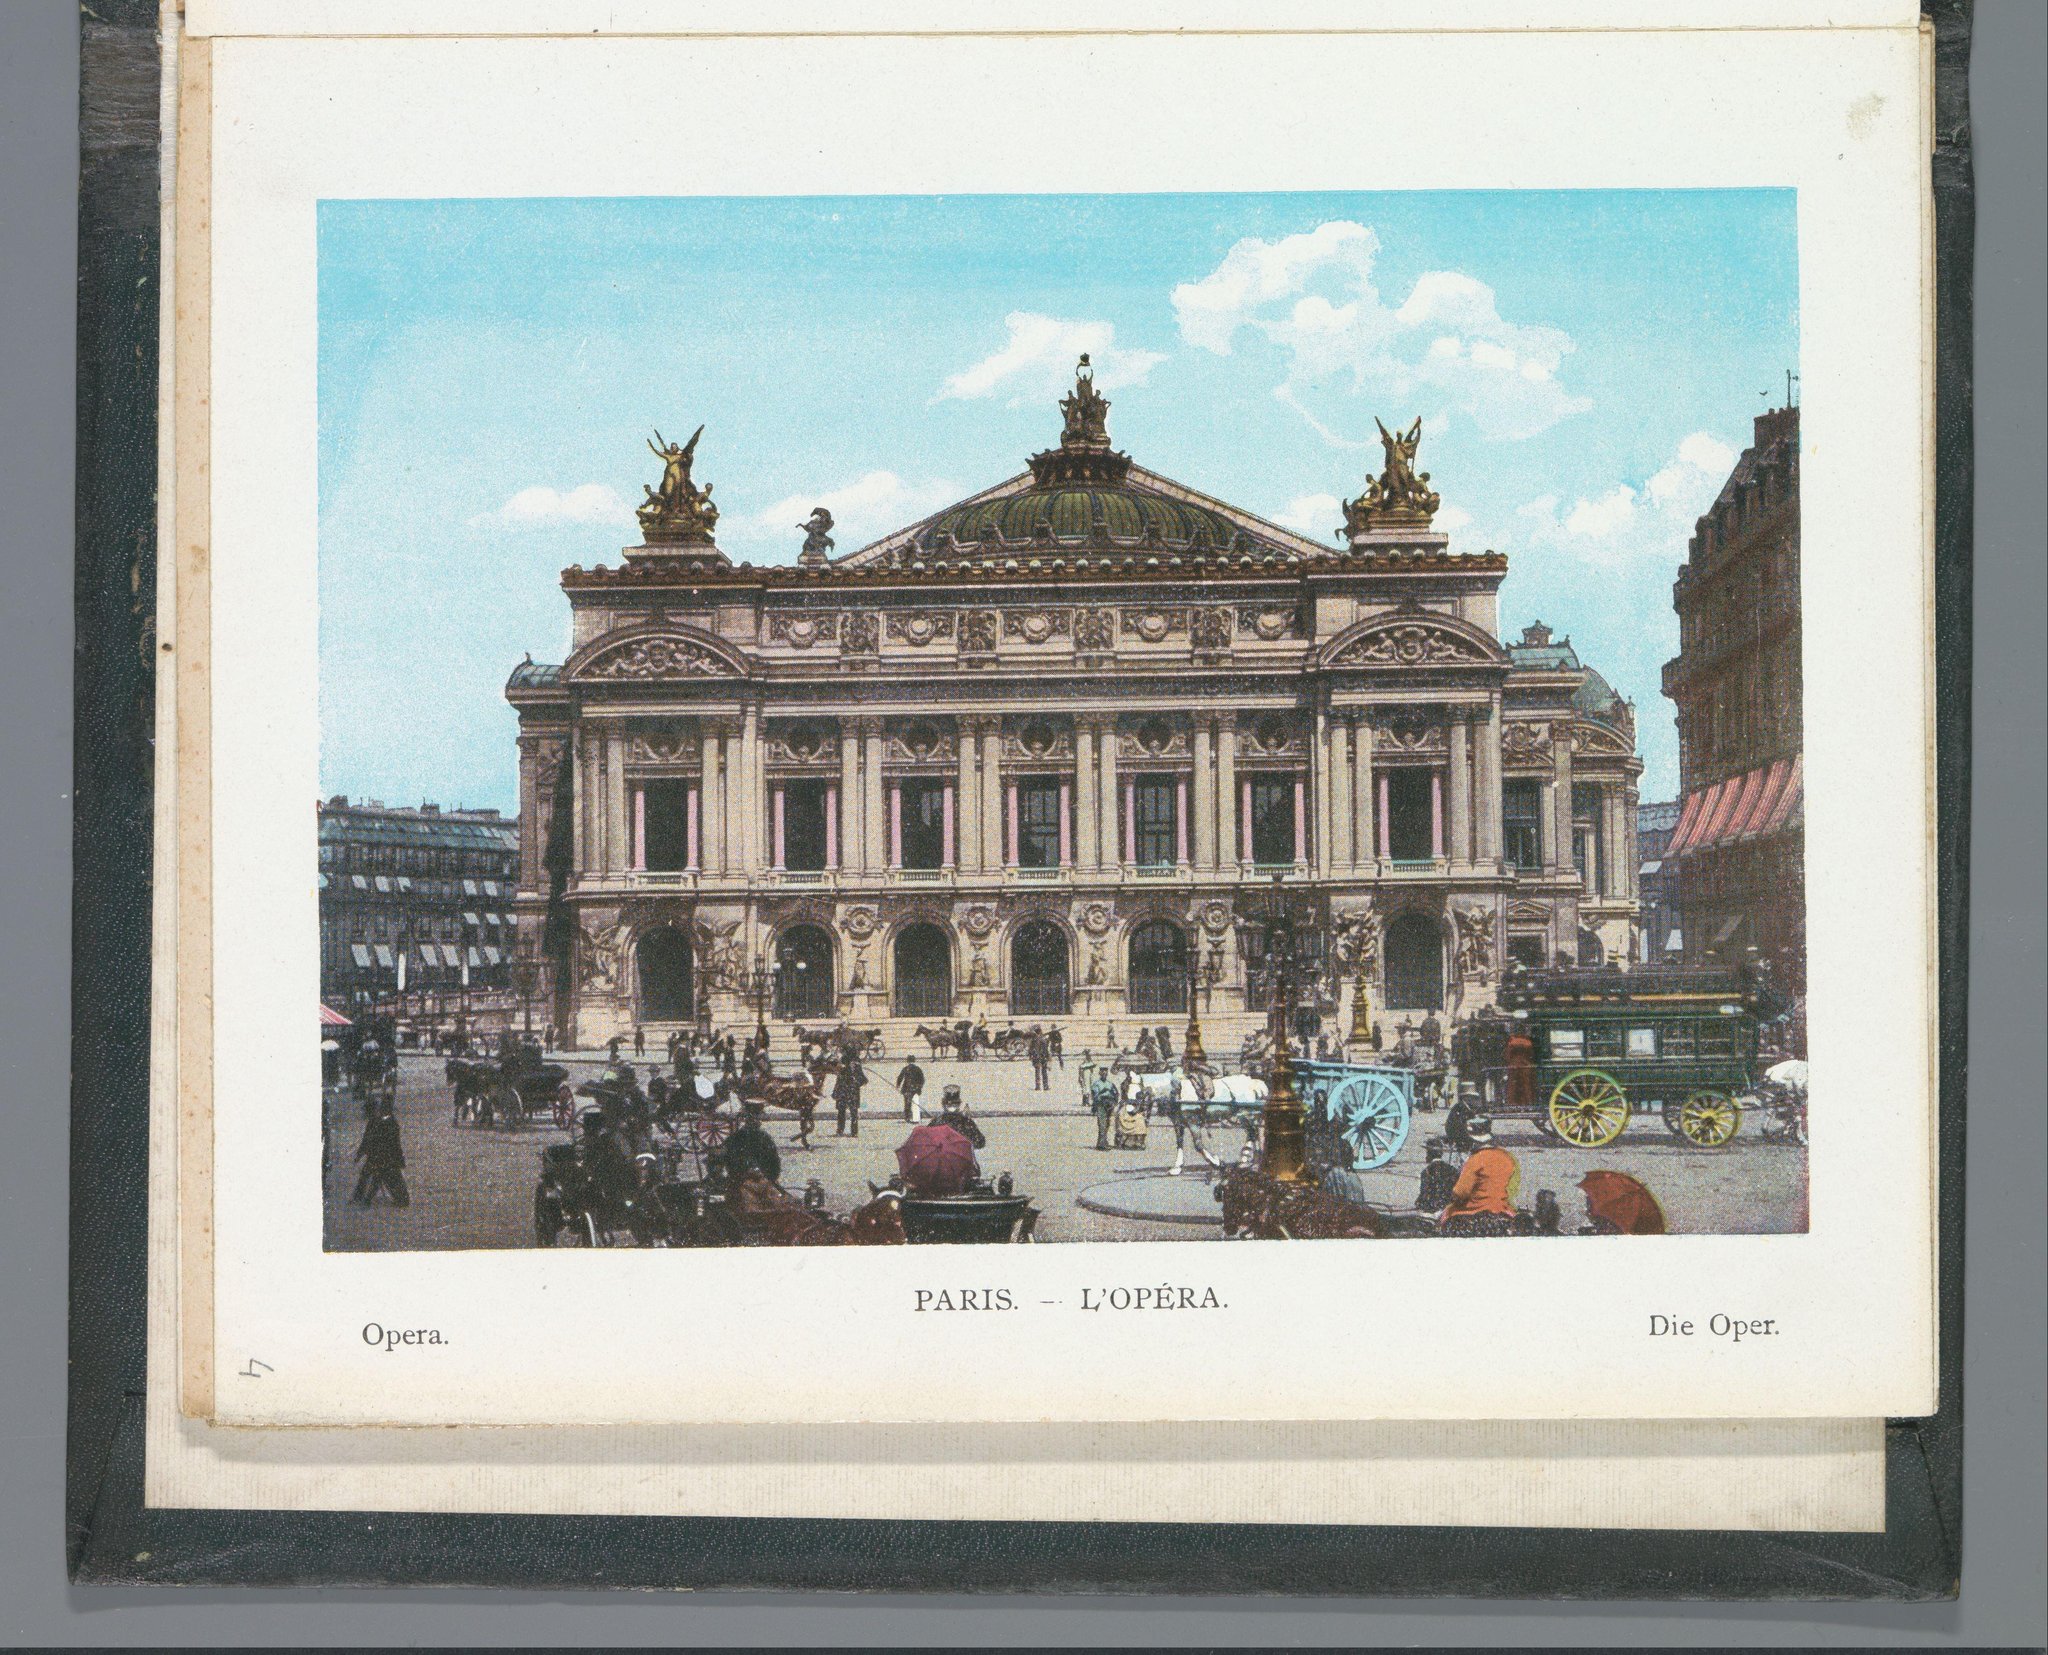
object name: page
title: Gezicht op het operagebouw van Parijs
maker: Anonymous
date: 1900-1930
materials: cardboard, paper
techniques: autotype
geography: paris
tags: animal traction, animal-drawn vehicle (carriage etc.), travelling; tourism, façade (of house or building), prospect of city, town panorama, silhouette of city, opera house, street (+ city(-scape) with figures, staffage), paris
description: Onderdeel van Fotoalbum met kleurenopnames van bezienswaardigheden in Parijs.